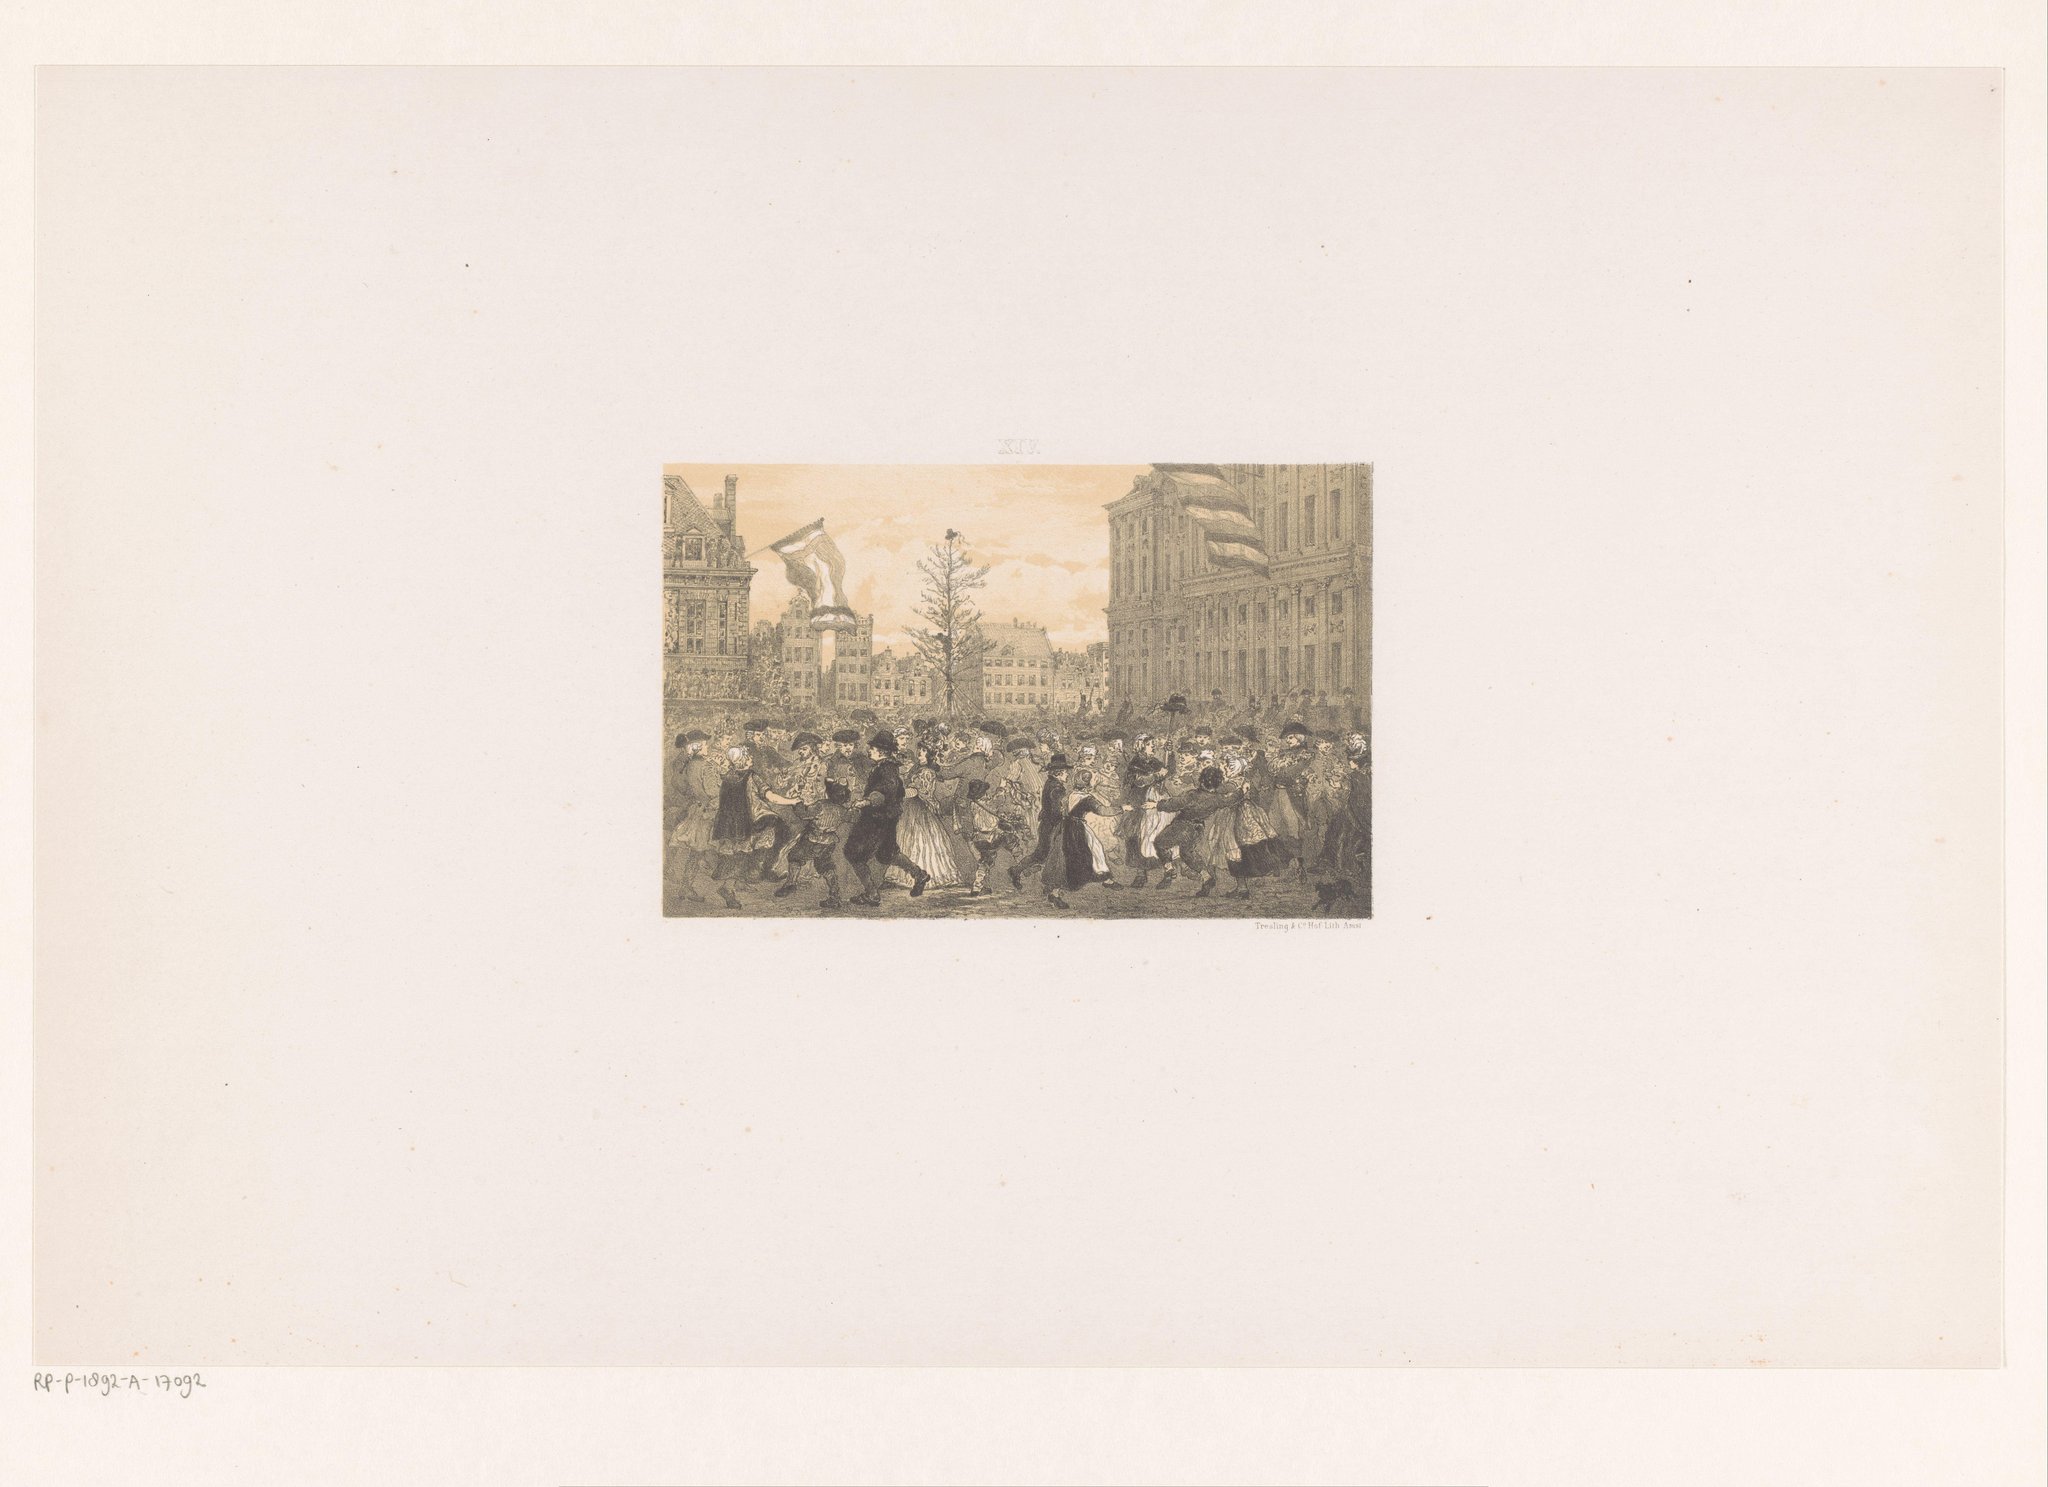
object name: print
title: De Vrijheidsboom op den Dam, op den 19n Januarij 1795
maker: johan conrad greive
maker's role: draughtsman, painter, print maker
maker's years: 1837-1891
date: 1876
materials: paper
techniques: tone lithography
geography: amsterdam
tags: dancing around the tree of liberty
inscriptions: collector's mark: Lugt 2228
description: Rechts het stadhuis van Amsterdam. De aanleiding was het uitroepen van de Bataafse Republiek op 4 maart 1795.